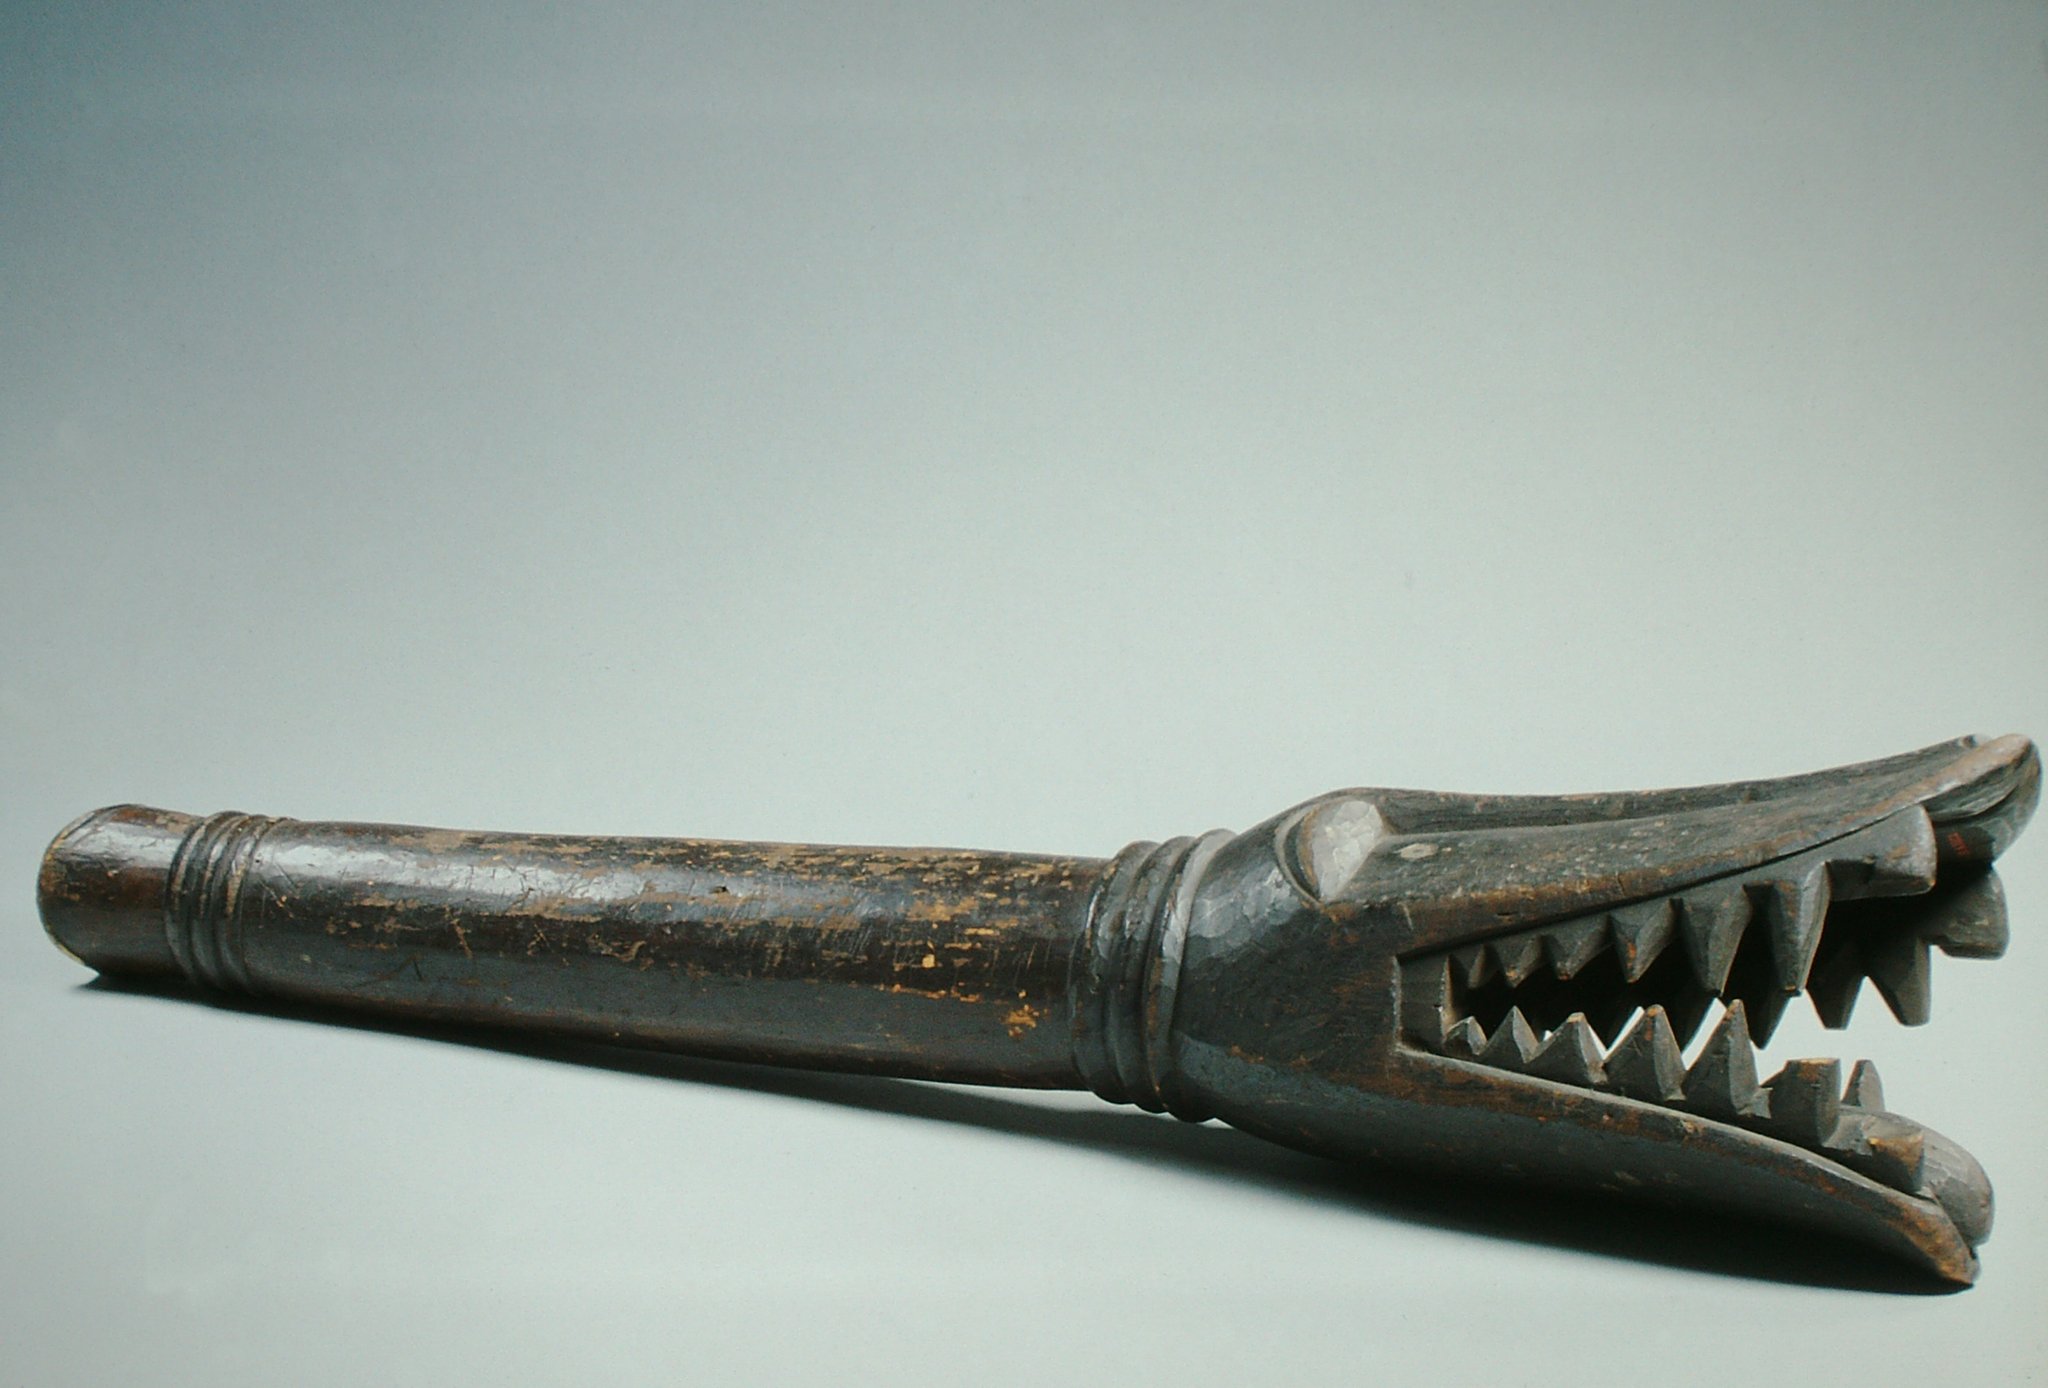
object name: megaphone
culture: congolese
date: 1701-1800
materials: wood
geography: congo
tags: crocodiles